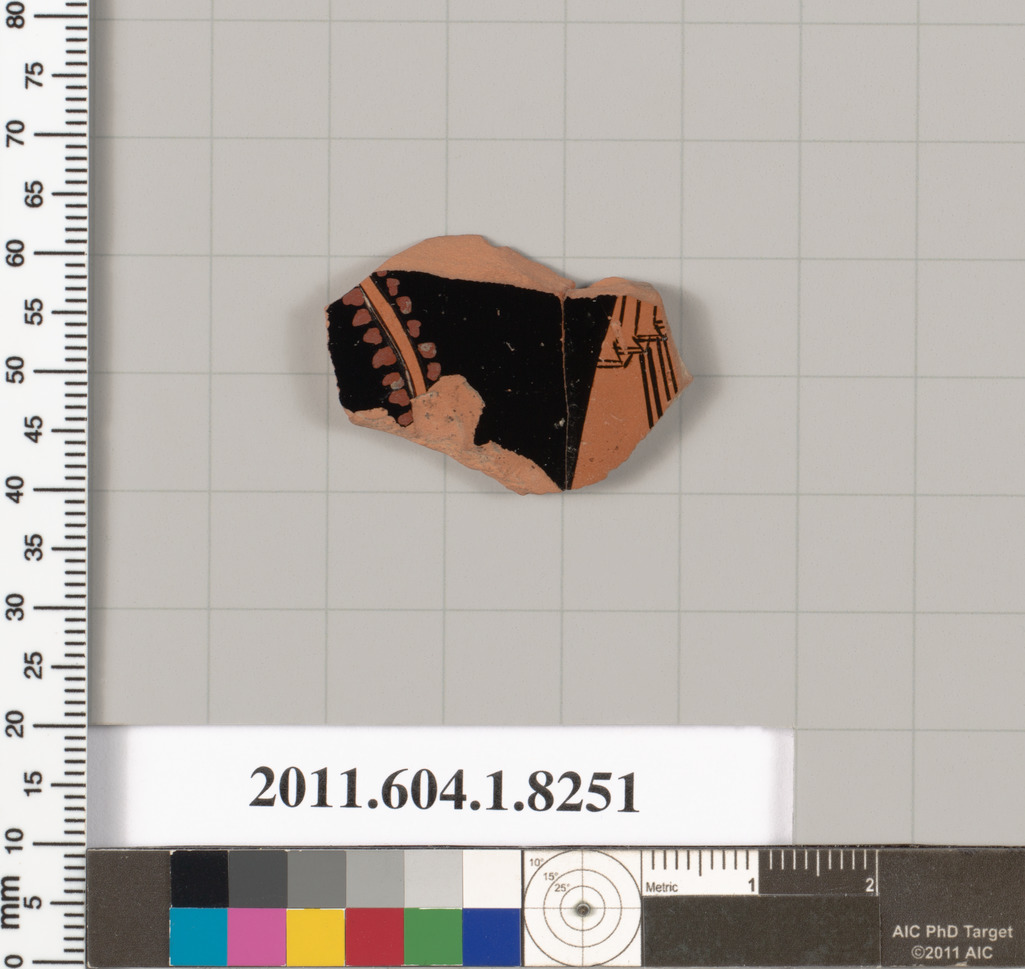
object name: kylix fragment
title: Terracotta fragment of a kylix (drinking cup)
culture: greek, attic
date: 520-510 BCE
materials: terracotta